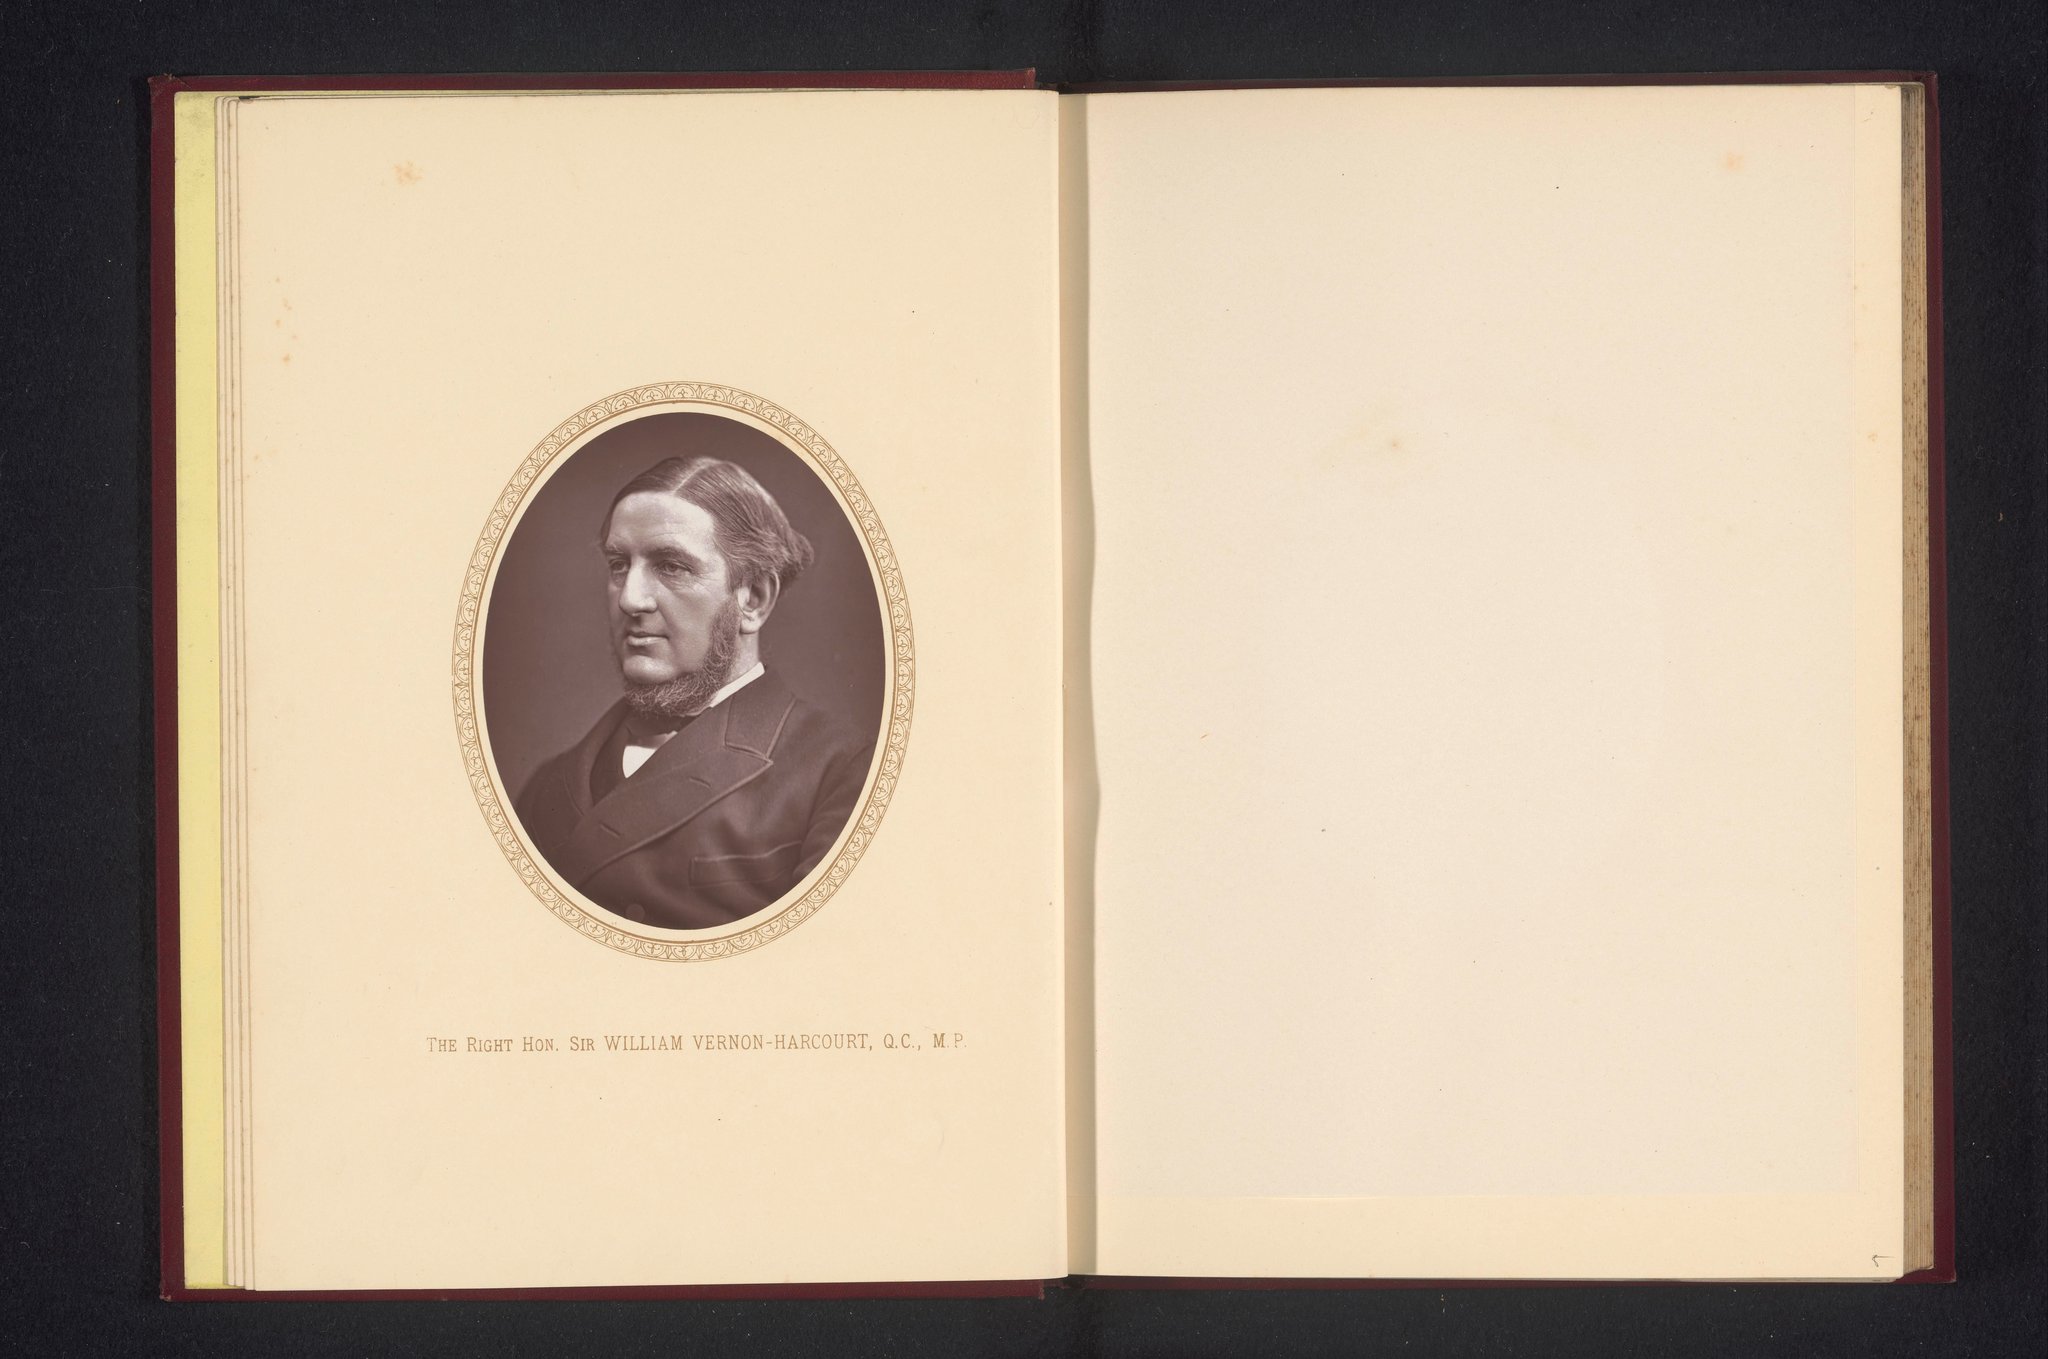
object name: photomechanical print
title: The right hon. Sir William Vernon-Harvourt, Q.C., M.P.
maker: Anonymous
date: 1875-1880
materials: paper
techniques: woodburytype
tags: politician, e.g. party leader